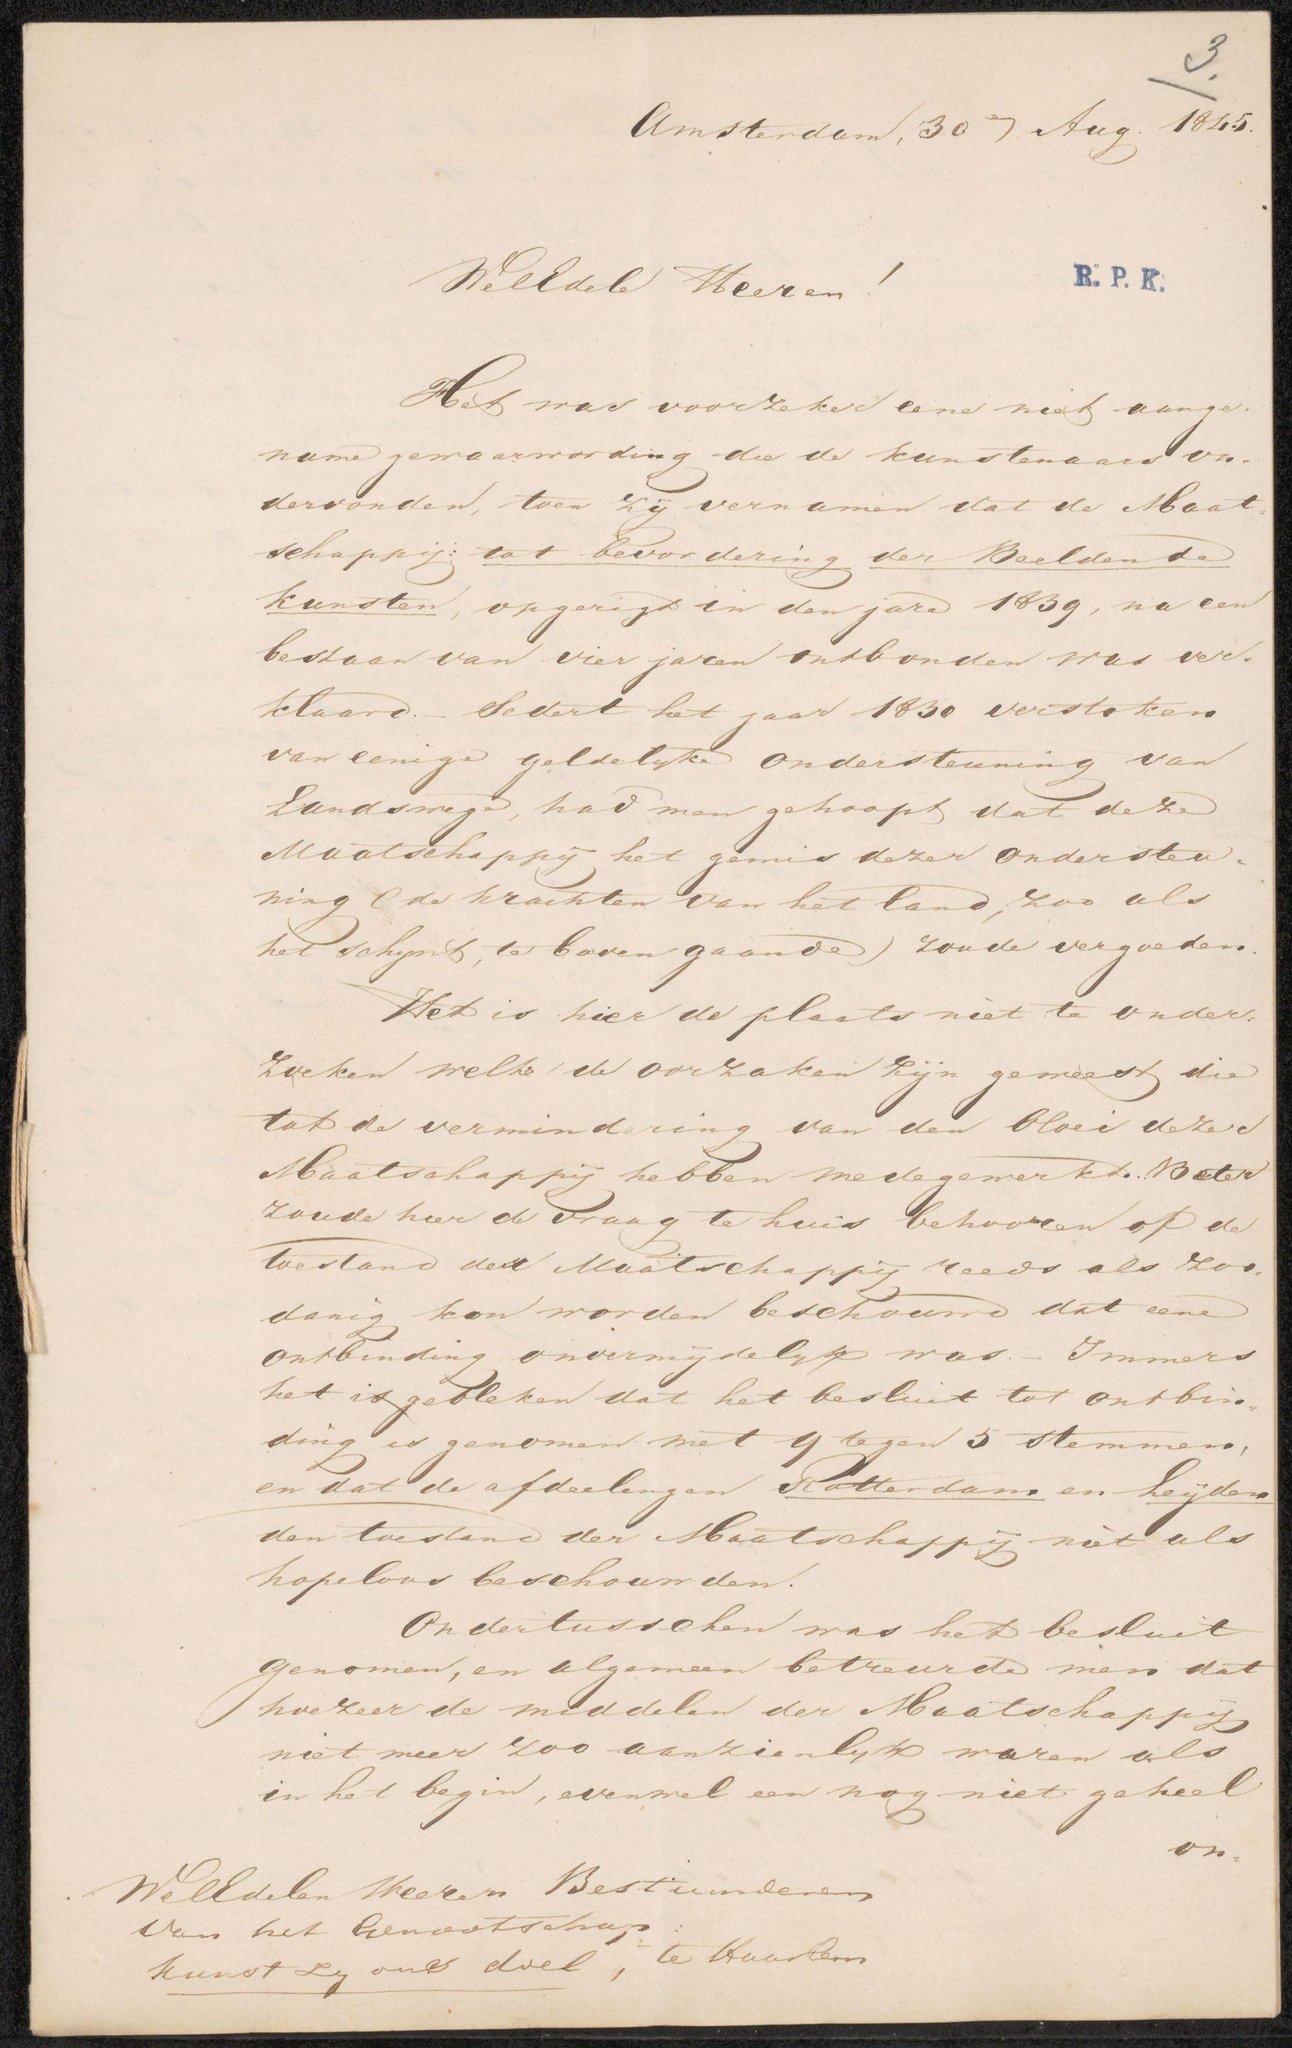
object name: letter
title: Brief aan de Maatschappij der Tekenkunst Kunst zy ons doel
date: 1845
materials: ink, paper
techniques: pen, writing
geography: amsterdam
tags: exhibition ~ art, leiden, rotterdam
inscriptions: watermark, collector's mark: Lugt 2233